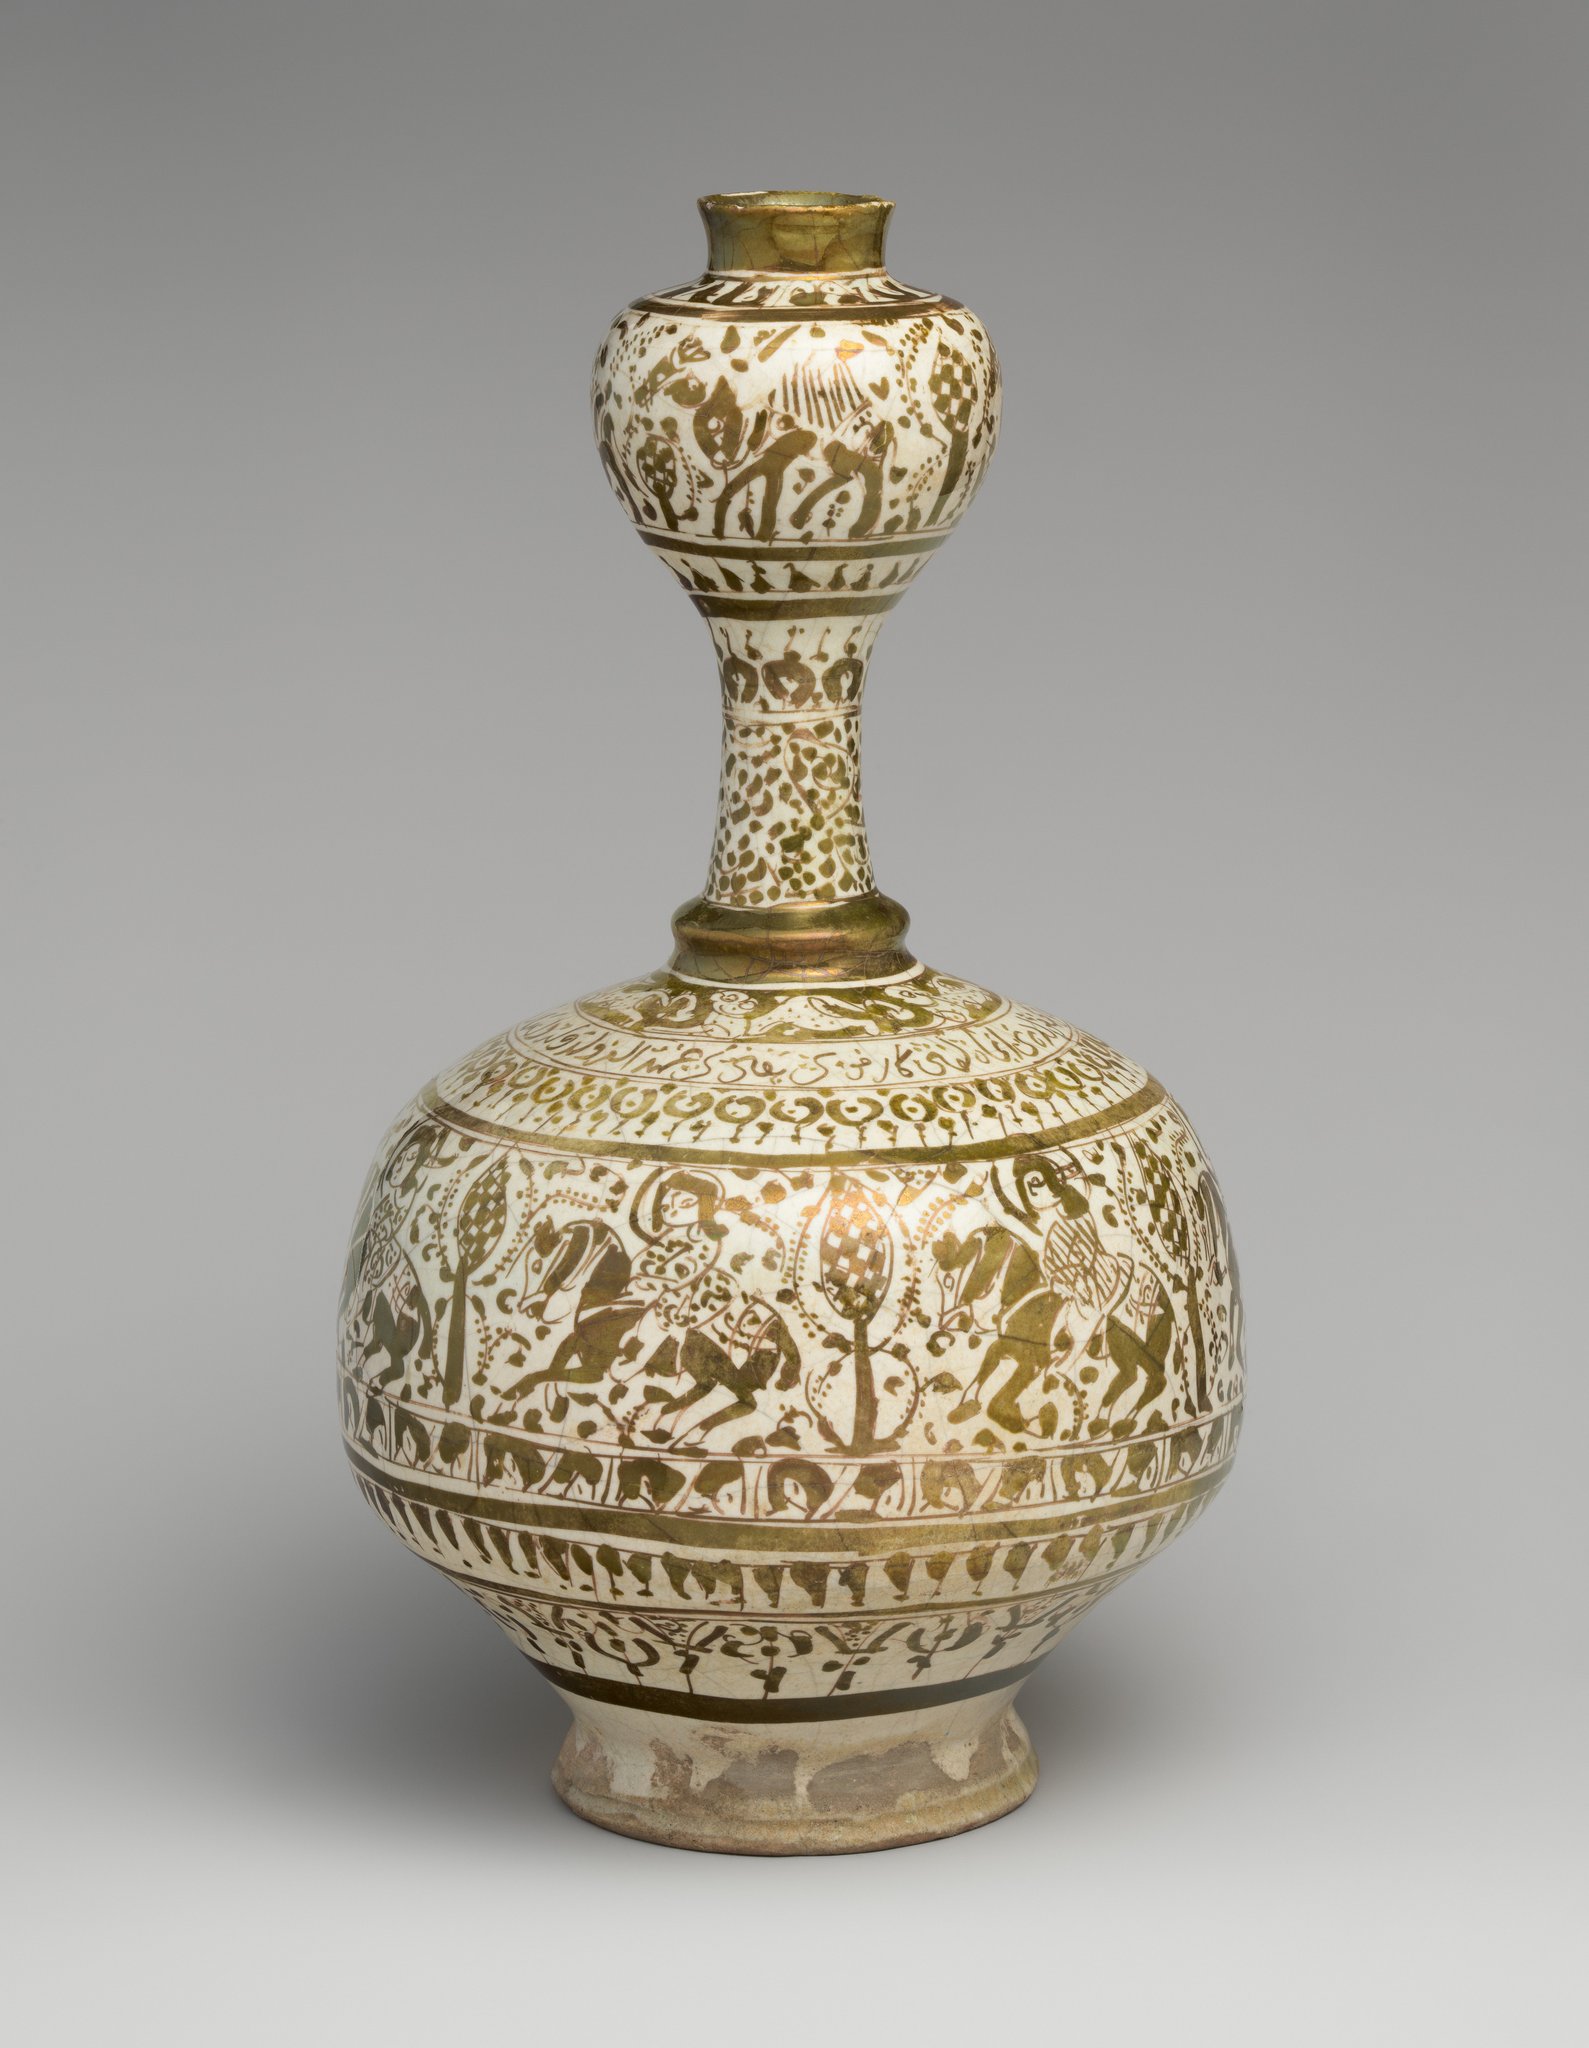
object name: bottle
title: Bottle with Bulb-Shaped Neck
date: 1101-1200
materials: glaze, stonepaste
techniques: luster painting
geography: iran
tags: horses